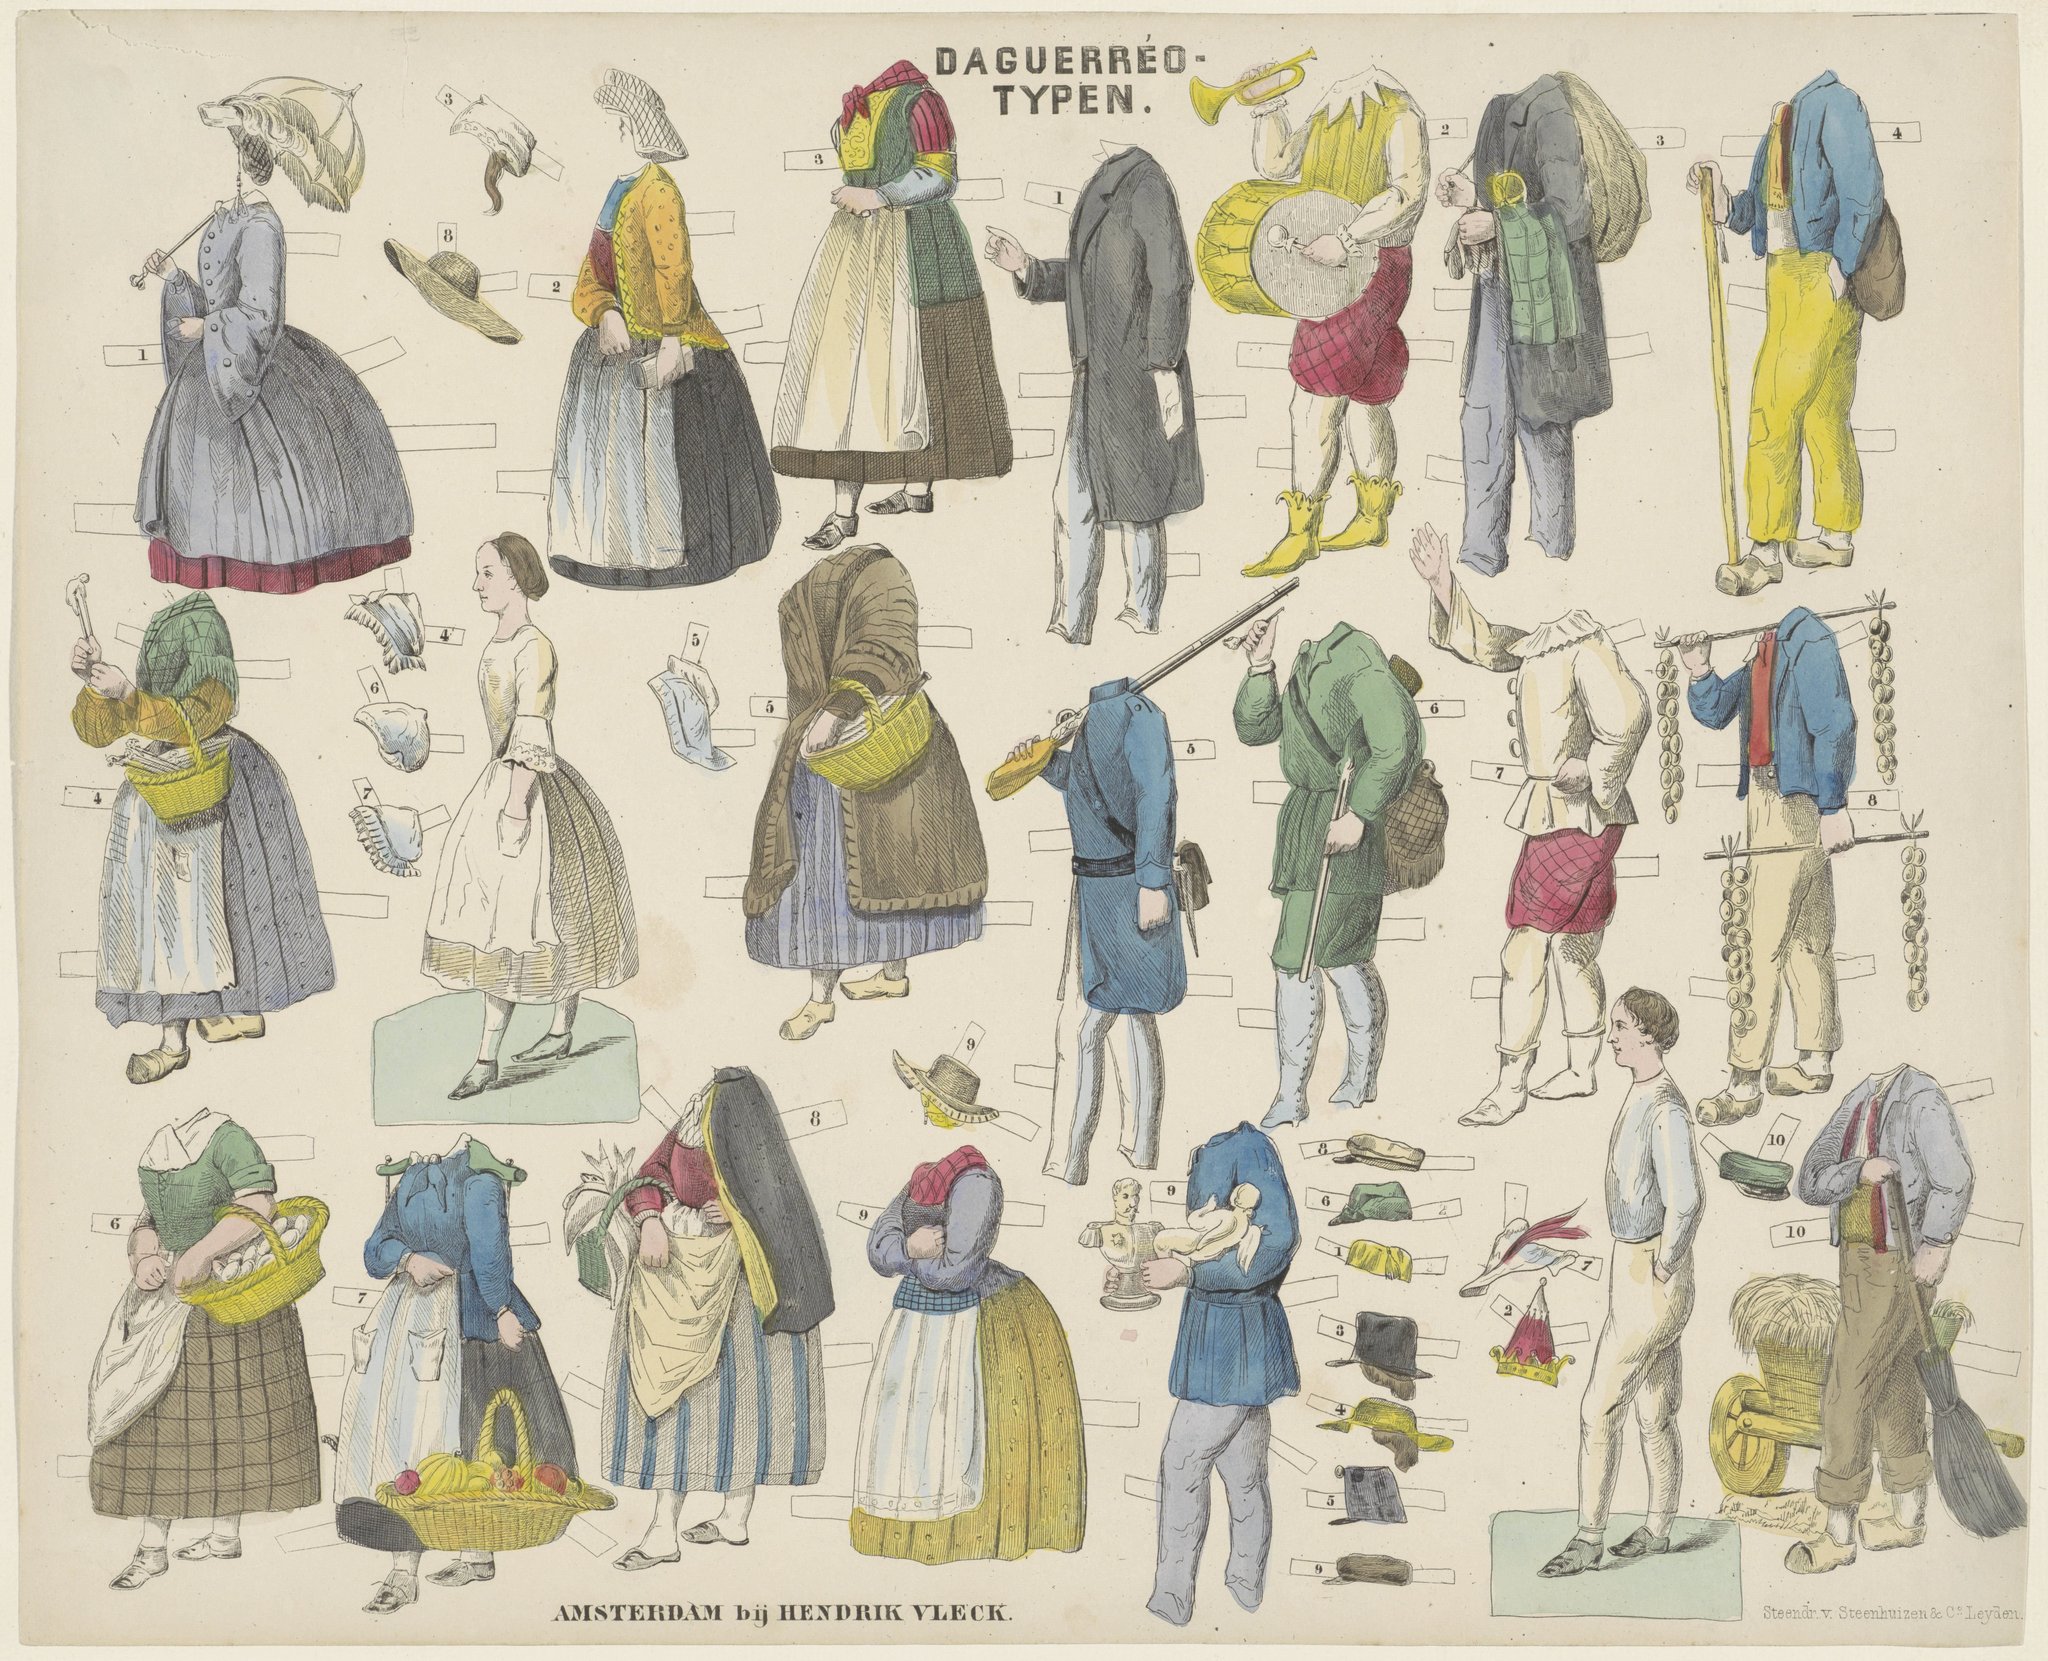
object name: popular print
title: Daguerréo- / typen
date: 1861-1865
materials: paper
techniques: hand coloring, lithograph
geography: leiden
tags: (playing with) cut-out constructions, clothes, costume (+ women's clothes), clothes, costume (+ men's clothes)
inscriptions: collector's mark: Lugt 2760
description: Blad met figuren om uit te knippen en mee te spelen. Links een vrouwenfiguur met zestien verschillende genummerde lijven en hoofddeksels. Rechts een mannenfiguur met twintig verschillende genummerde lijven en hoofddeksels.